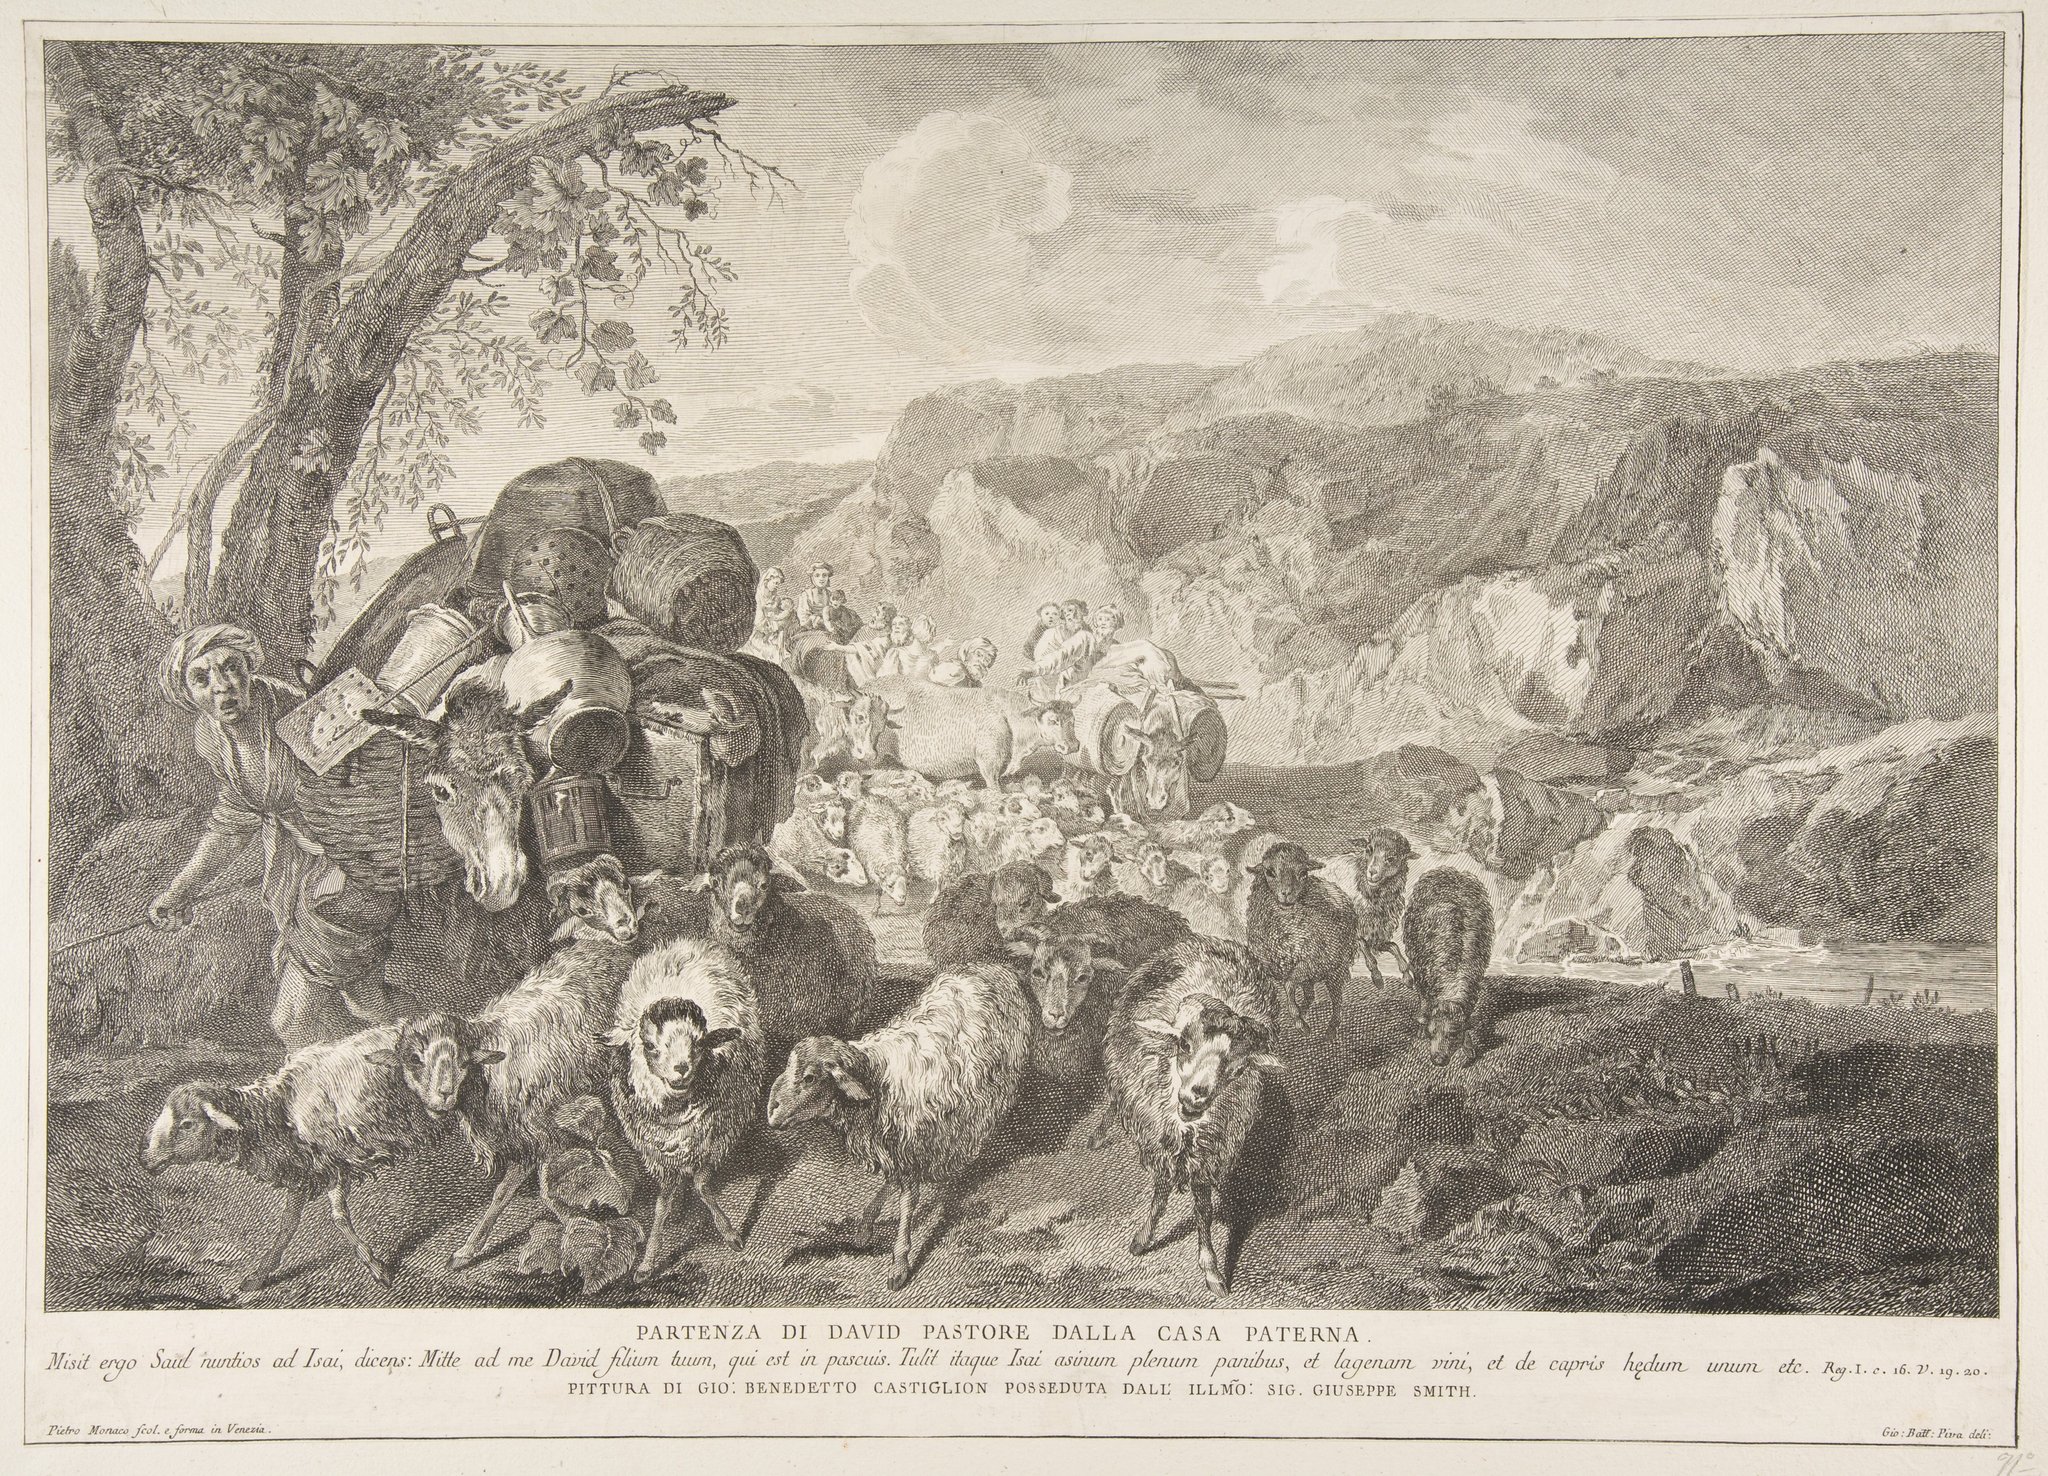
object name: print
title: Departure of David the Shepherd from the House of His Father (Partenza di David pastore dalla casa paterna)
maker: pietro monaco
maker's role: artist and publisher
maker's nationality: italian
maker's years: 1707-1772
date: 1743-1763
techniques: etching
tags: men,donkeys,sheep,david,shepherds